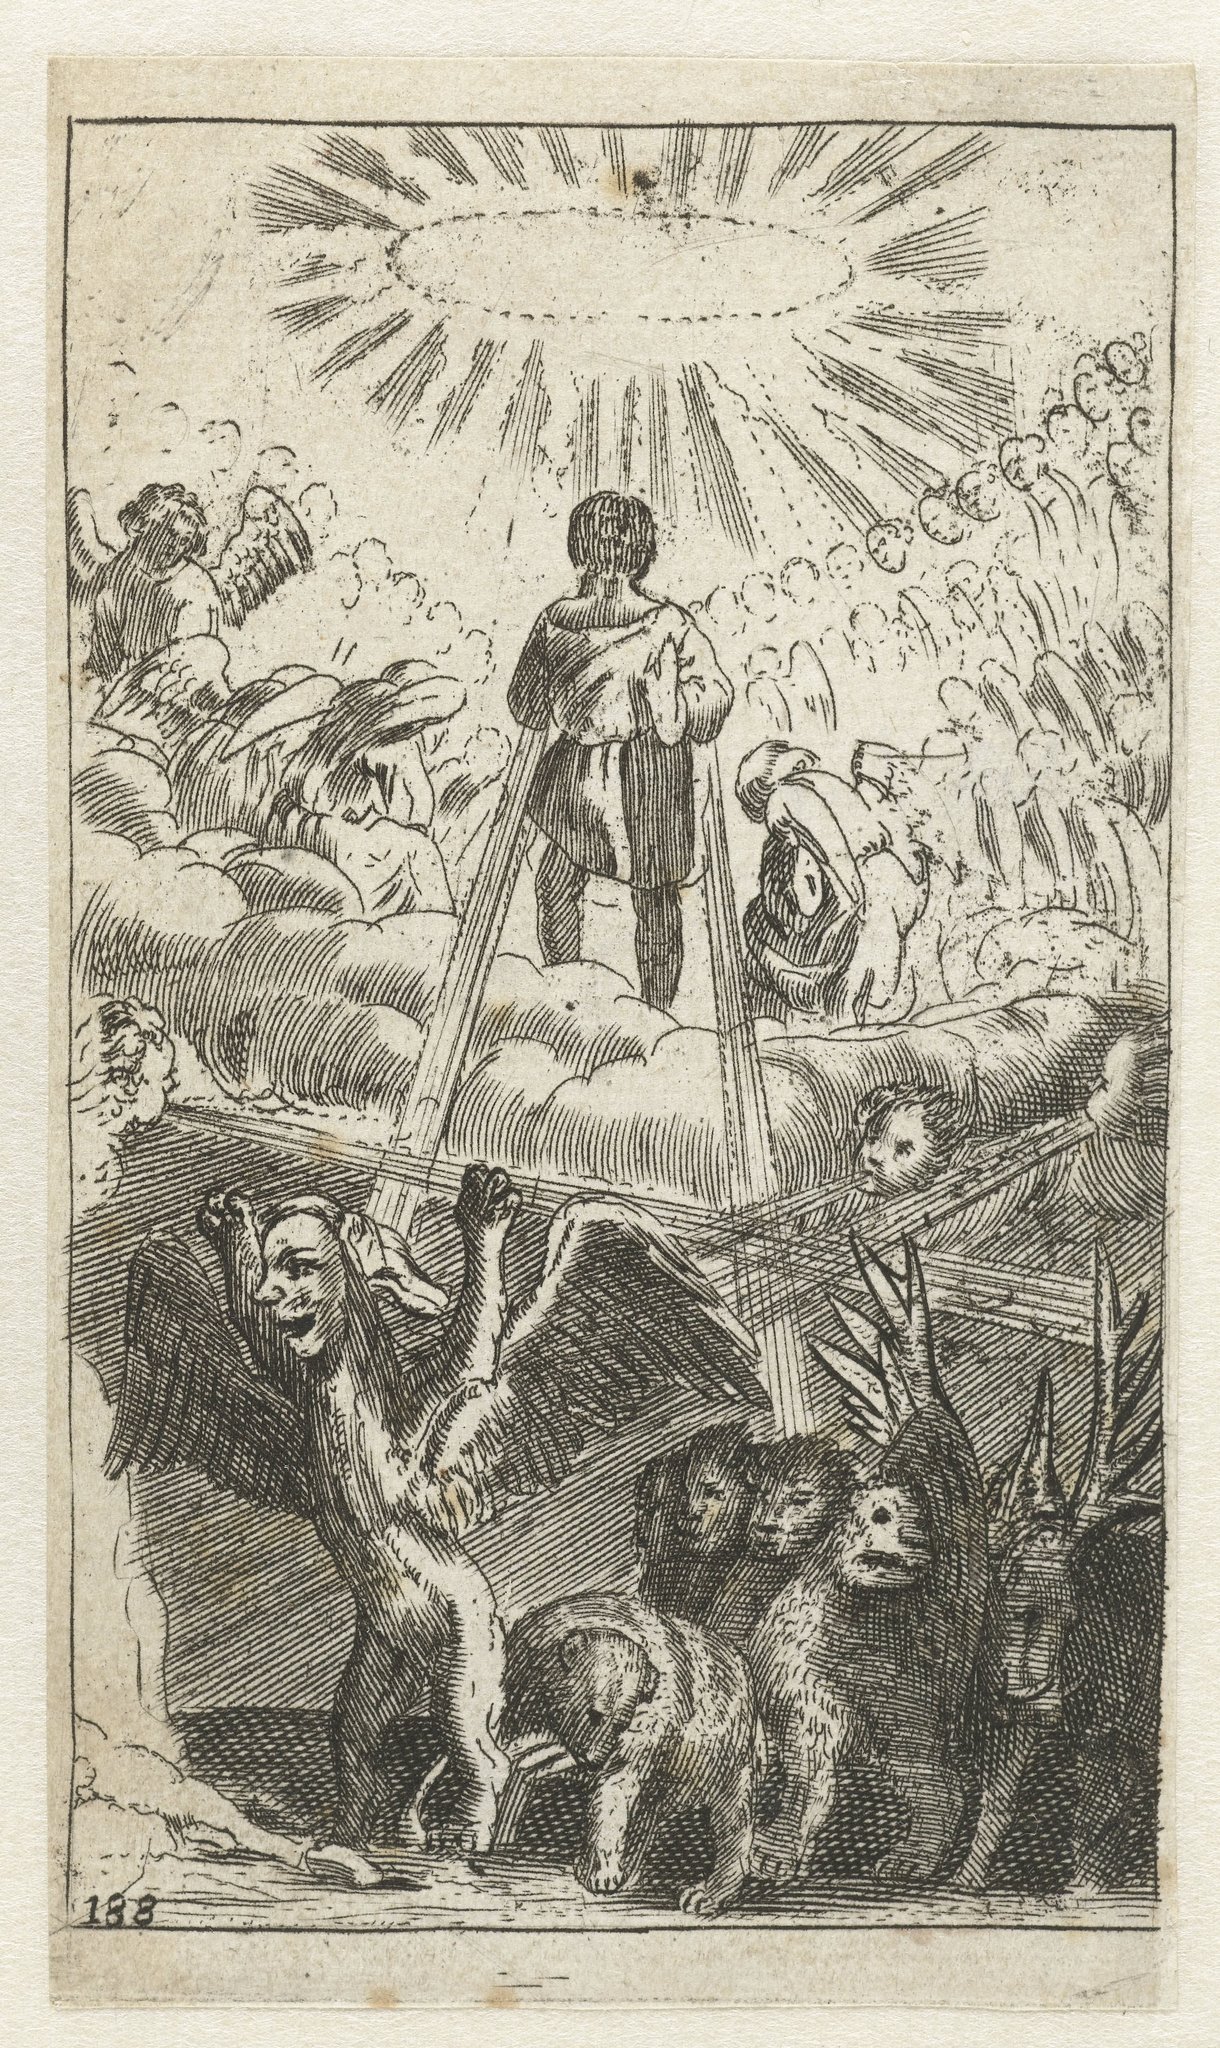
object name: print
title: Daniel’s vision of four beasts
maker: salomon italia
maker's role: print maker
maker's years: 1619-1665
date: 1655-1665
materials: paper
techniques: engraving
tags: daniel's visions (daniel may be shown having his visions explained, e.g. by the archangel gabriel)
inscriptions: collector's mark: Lugt 240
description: Kopie naar de gelijknamige prent van Rembrandt, gebruikt voor: Israel, Menasseh Ben. Piedra Gloriosa de la estatua de Nebuchadnesar. Amsterdam: s.n., 1655. De kopie is voor andere edities van hetzelfde boek gebruikt.